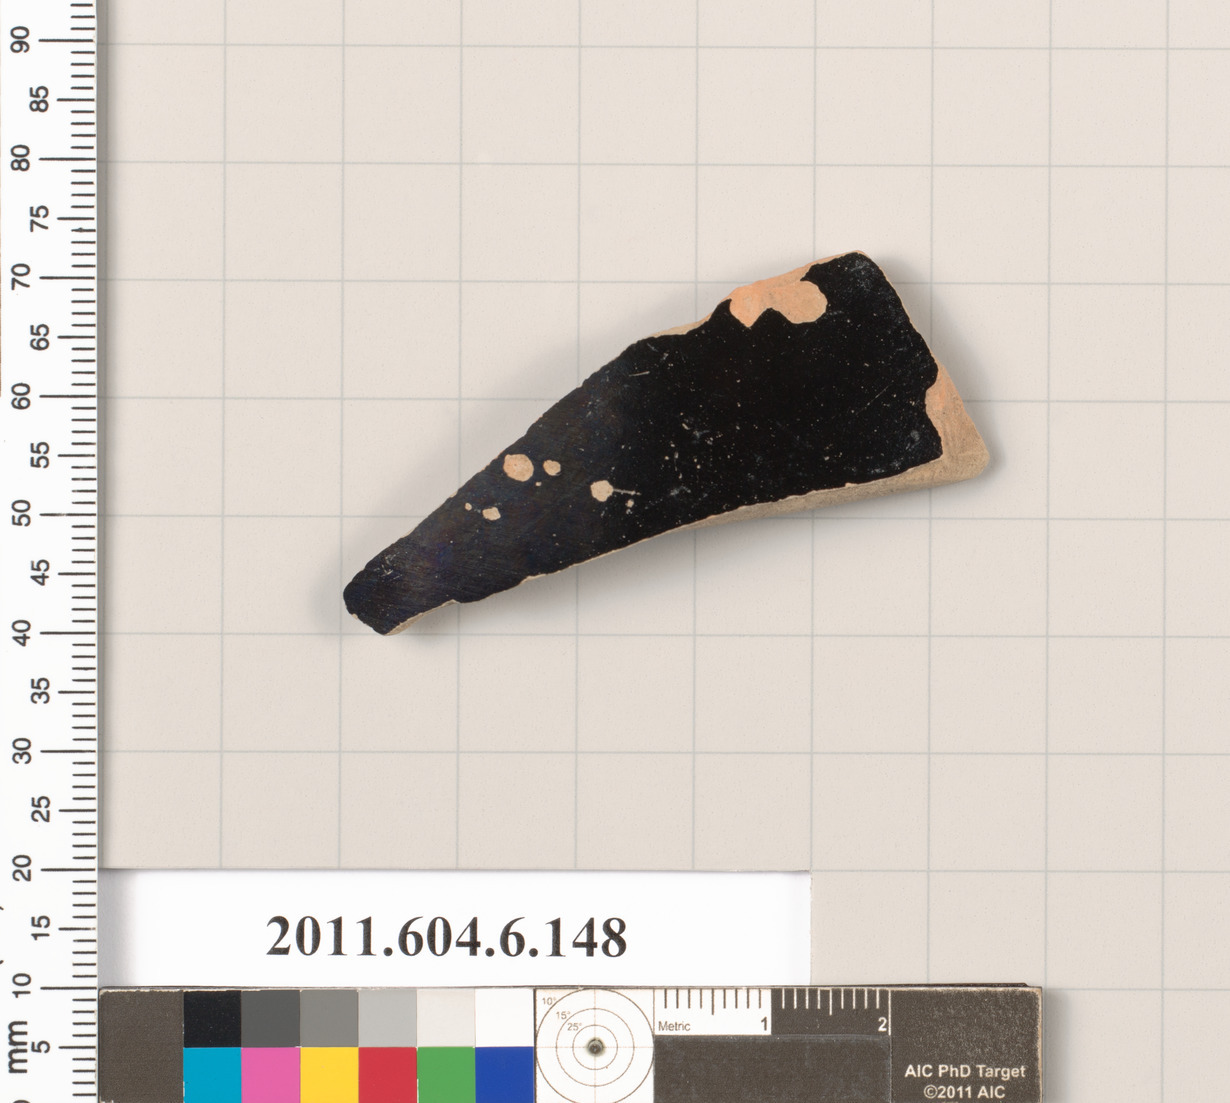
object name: undetermined open shape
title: Terracotta fragment of an open shape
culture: greek, attic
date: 600-401 BCE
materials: terracotta